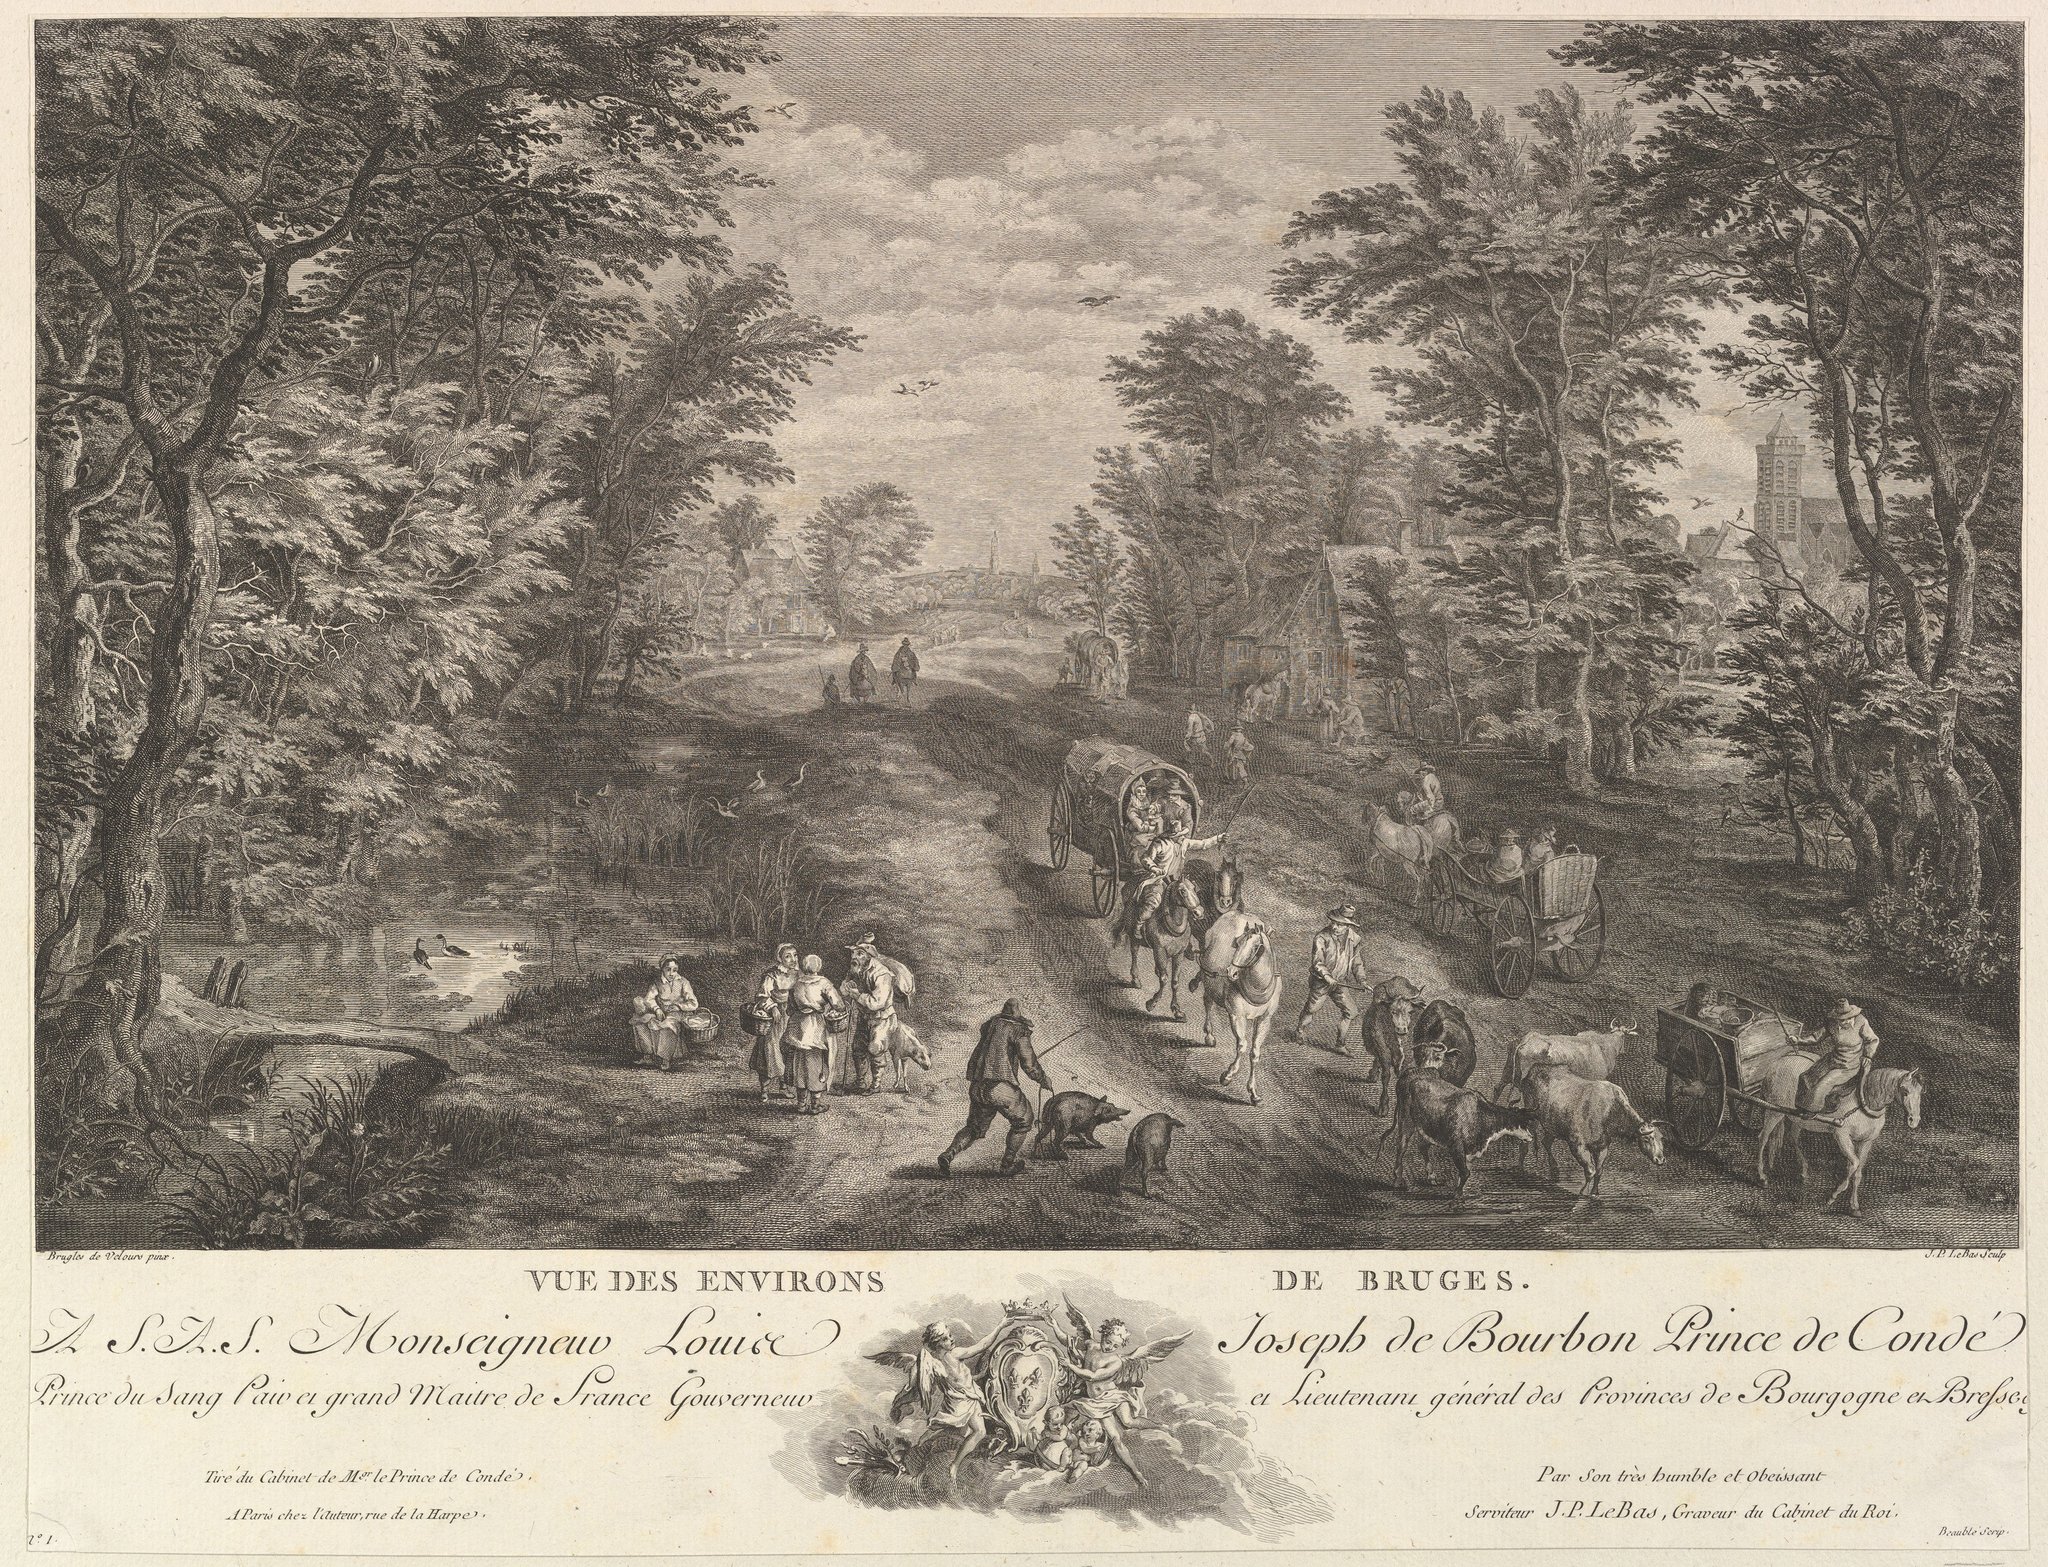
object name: print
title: View of the Surroundings of Bruges (Vue des environs de Bruges)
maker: jacques philippe le bas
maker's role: artist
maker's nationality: french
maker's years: 1707-1783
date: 1700-1780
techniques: engraving, etching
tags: roads,men,women,horses,carriages